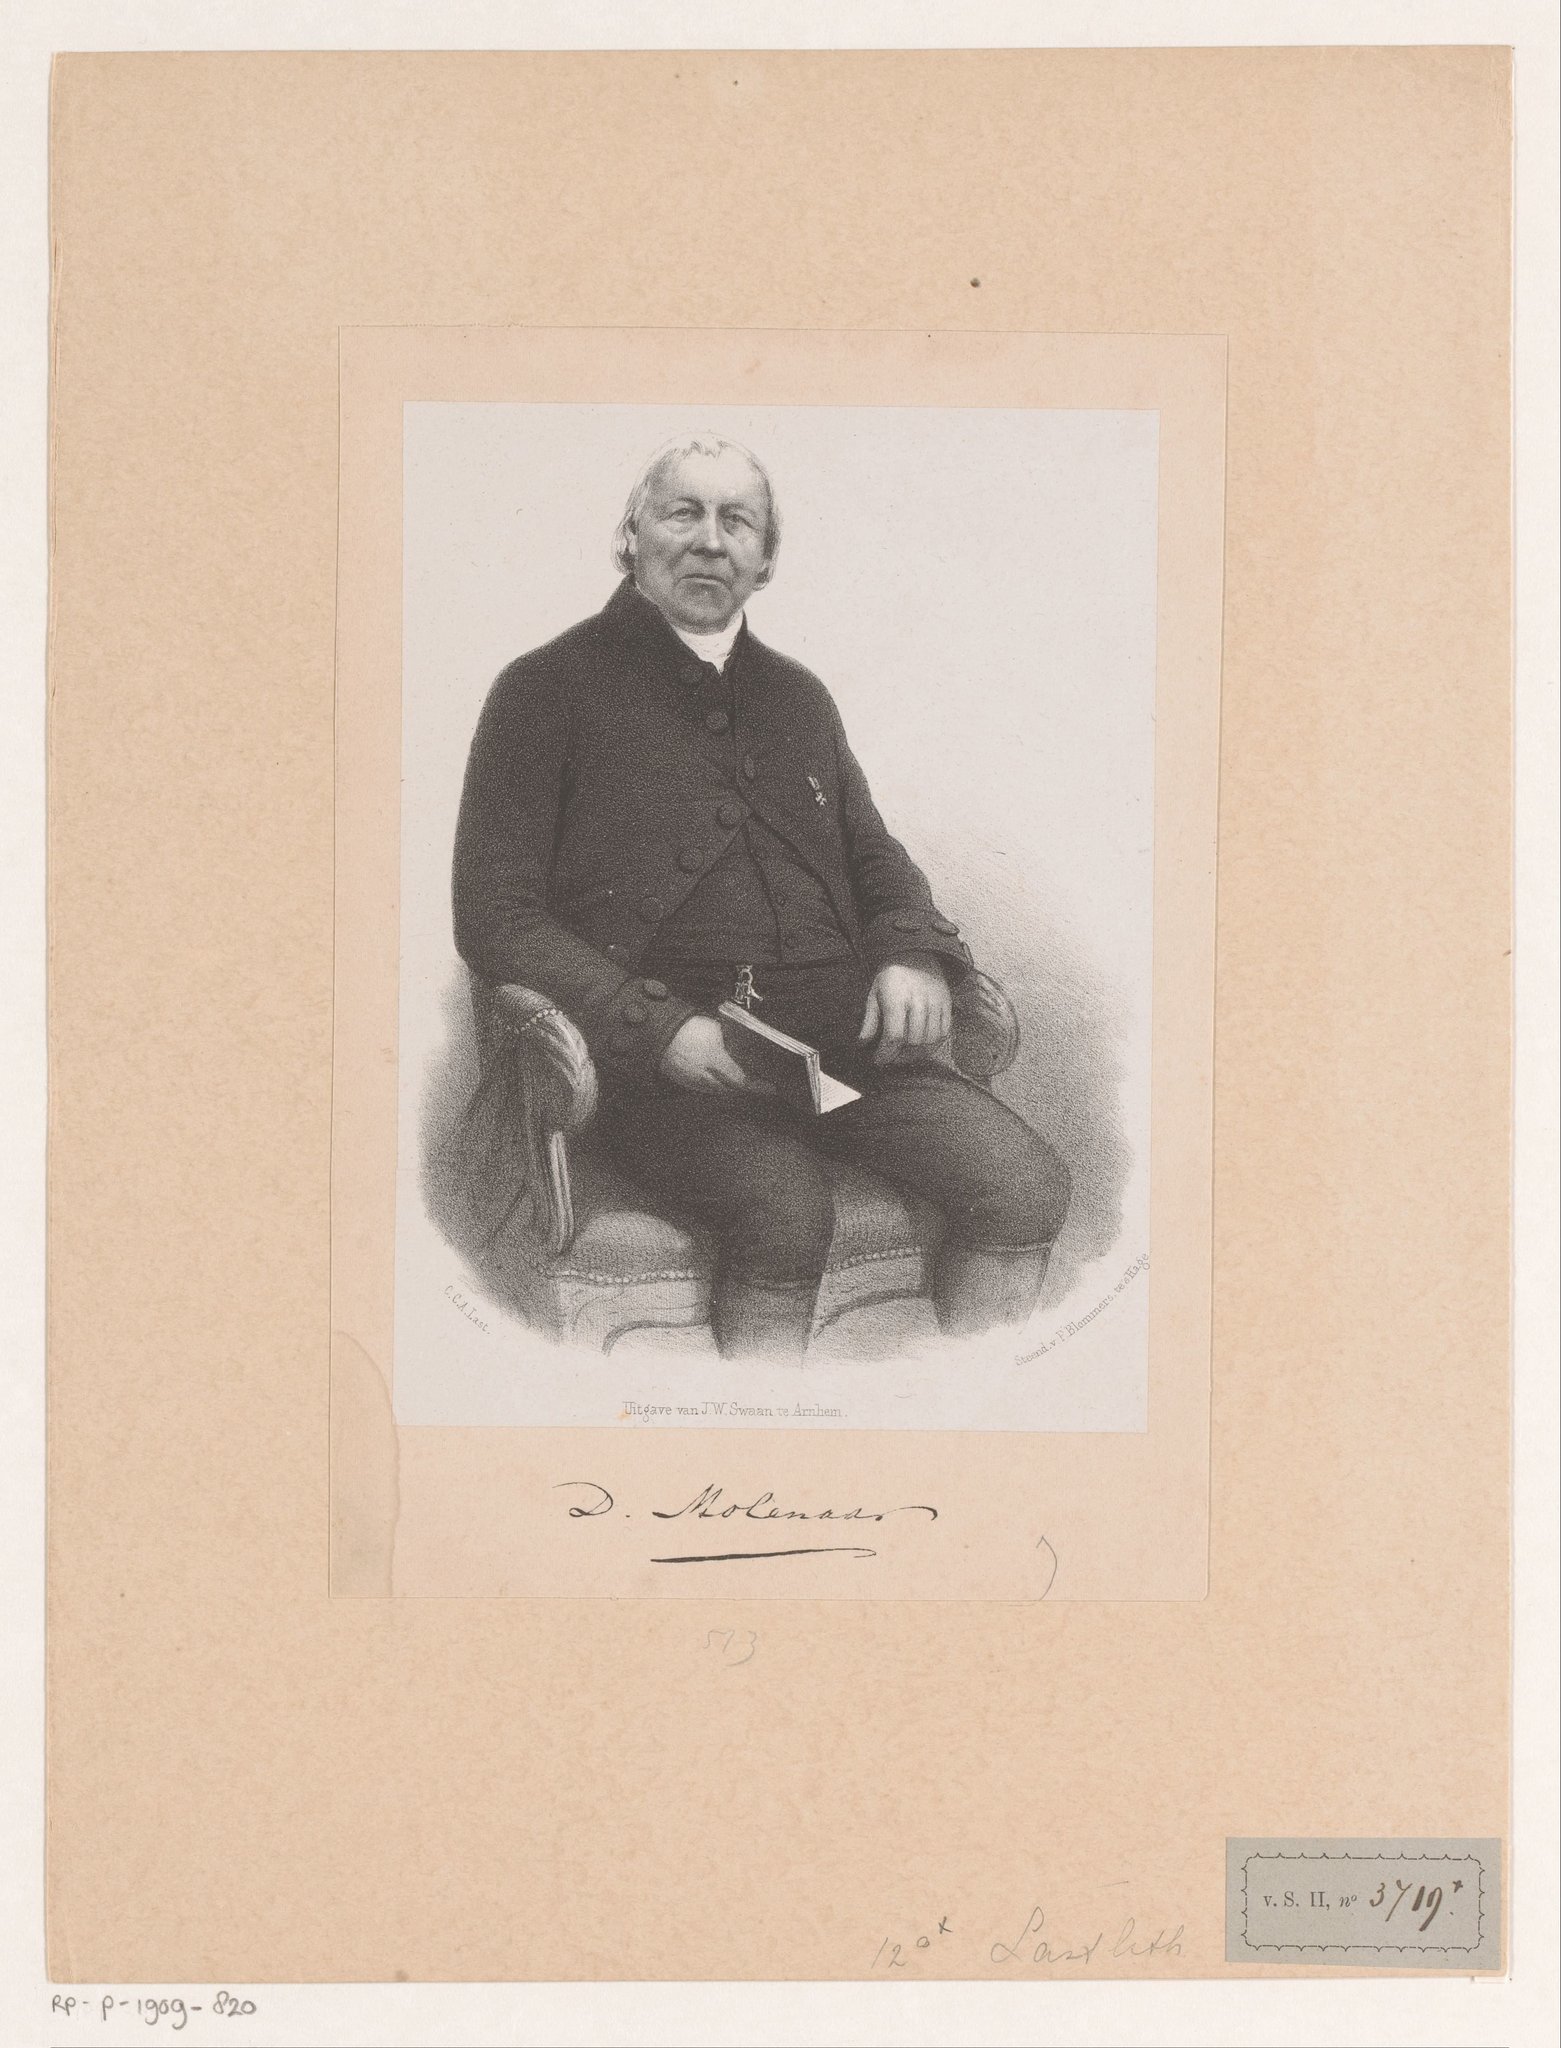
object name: print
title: Portret van Dirk Molenaar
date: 1842-1887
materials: paper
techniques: lithograph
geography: arnhem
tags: knighthood order, book - mm - book open, historical persons (+ three-quarter length portrait)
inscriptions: collector's mark: Lugt 2228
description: De geportretteerde zit op een stoel met een open boek in zijn rechterhand. Op zijn borst draagt hij een ridderorde. Onder het portret zijn signatuur.